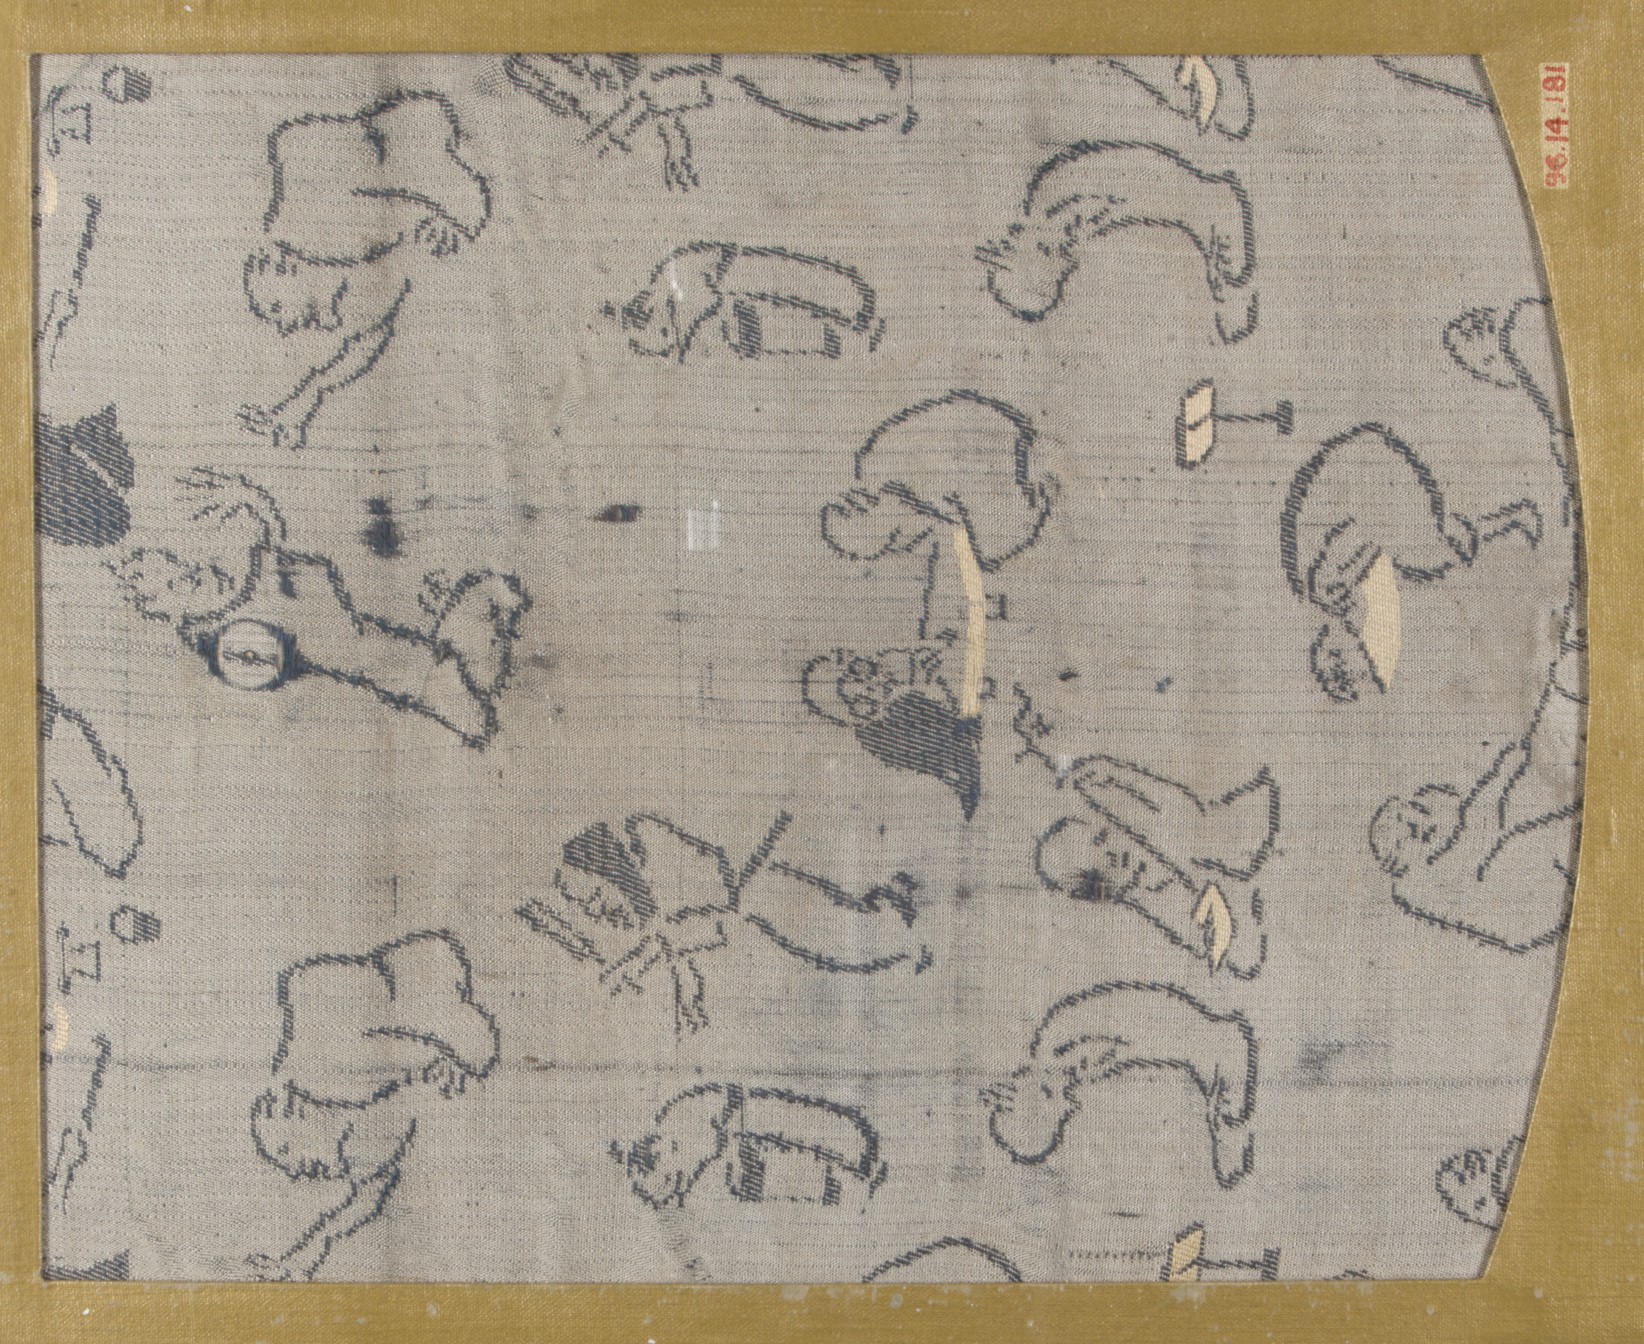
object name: fragment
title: Textile fragment with pattern of human figures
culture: japanese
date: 1701-1900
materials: silk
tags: human figures